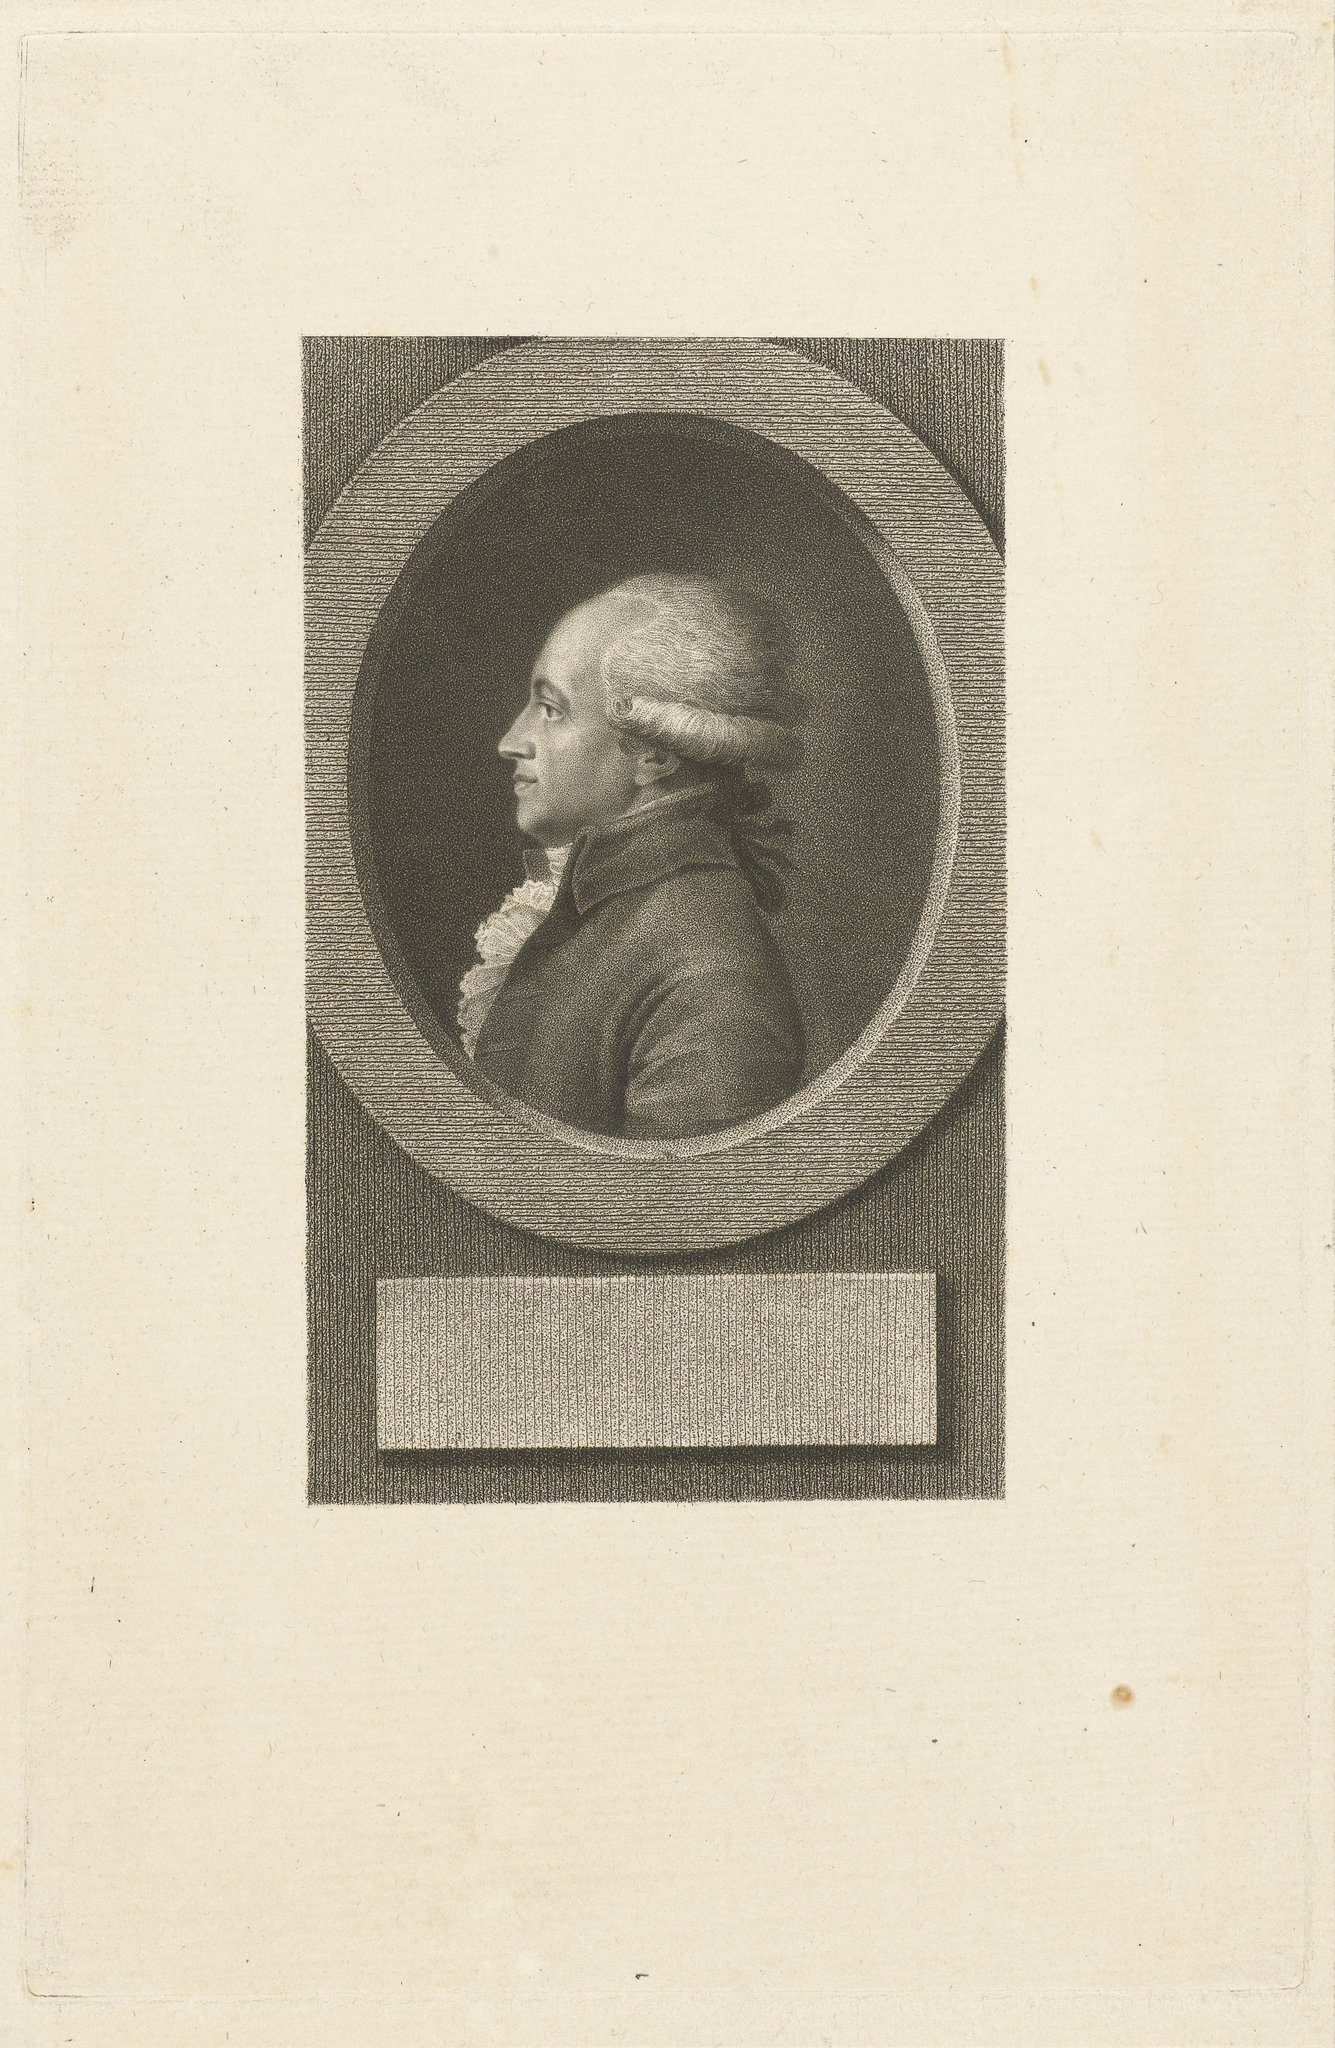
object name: print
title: Portret van Jean Rewbel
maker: lambertus antonius claessens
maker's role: draughtsman, print maker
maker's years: 1763-1834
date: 1792-1808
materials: paper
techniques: etching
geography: amsterdam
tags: revolutionair, jean rewbel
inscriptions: collector's mark: Lugt 2228